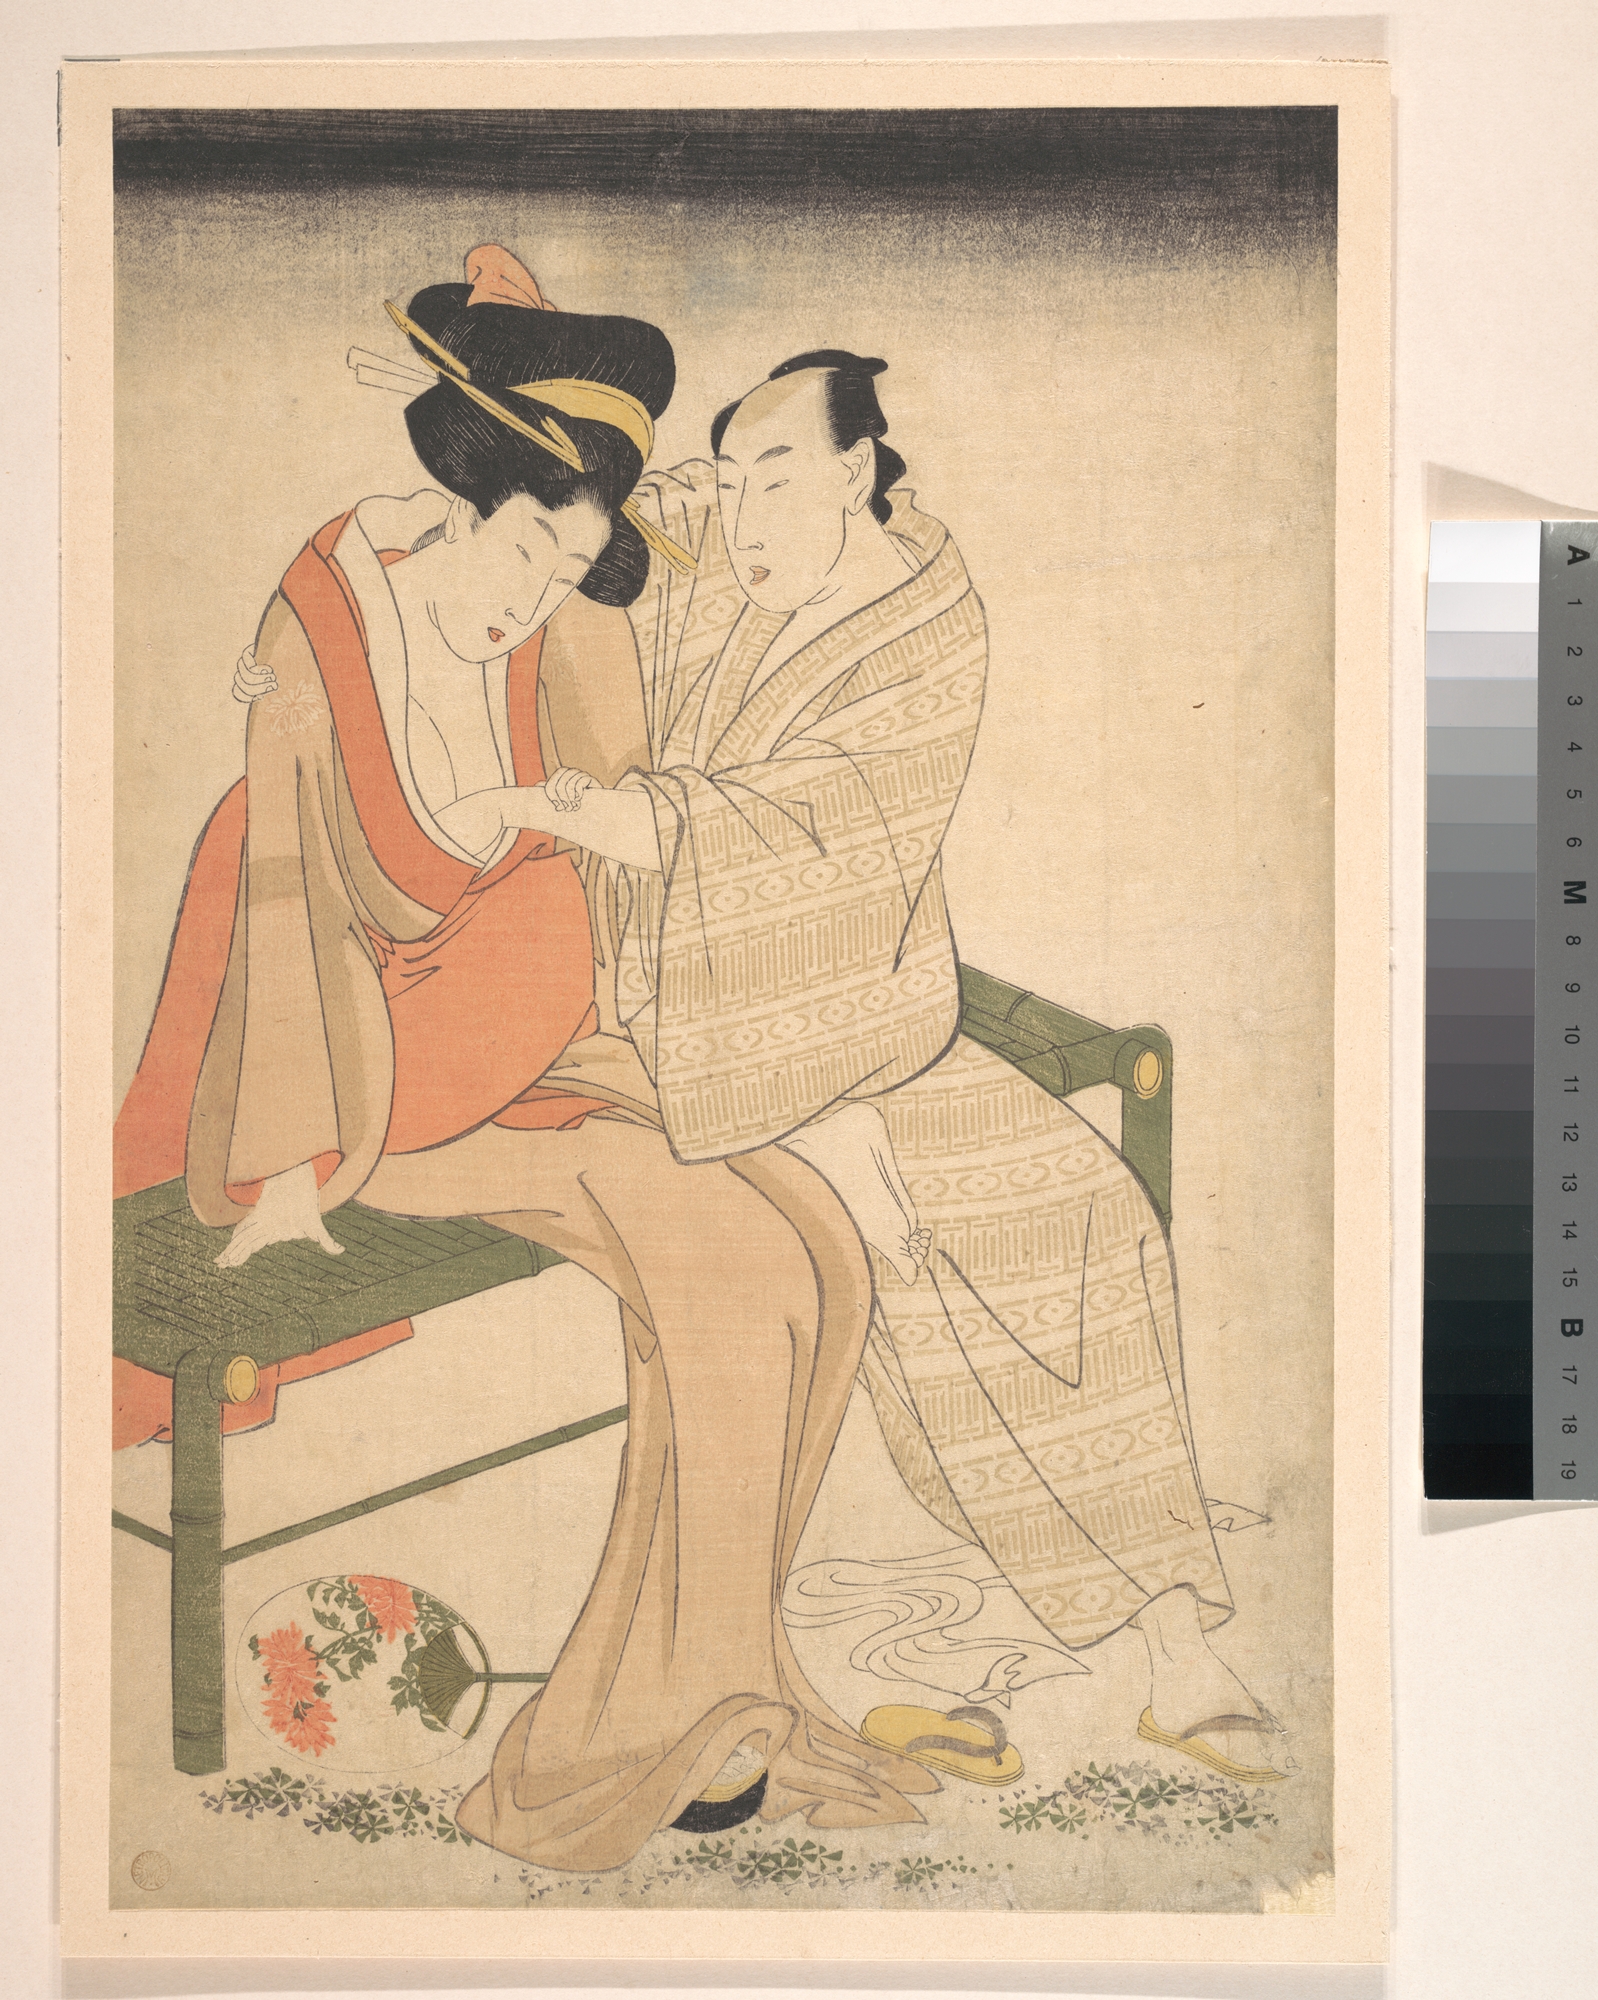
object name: print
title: A Pair of Lovers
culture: japanese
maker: kitagawa utamaro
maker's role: artist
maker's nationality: japanese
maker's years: 1754-1806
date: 1795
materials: ink, paper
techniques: woodblock print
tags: couples,men,women